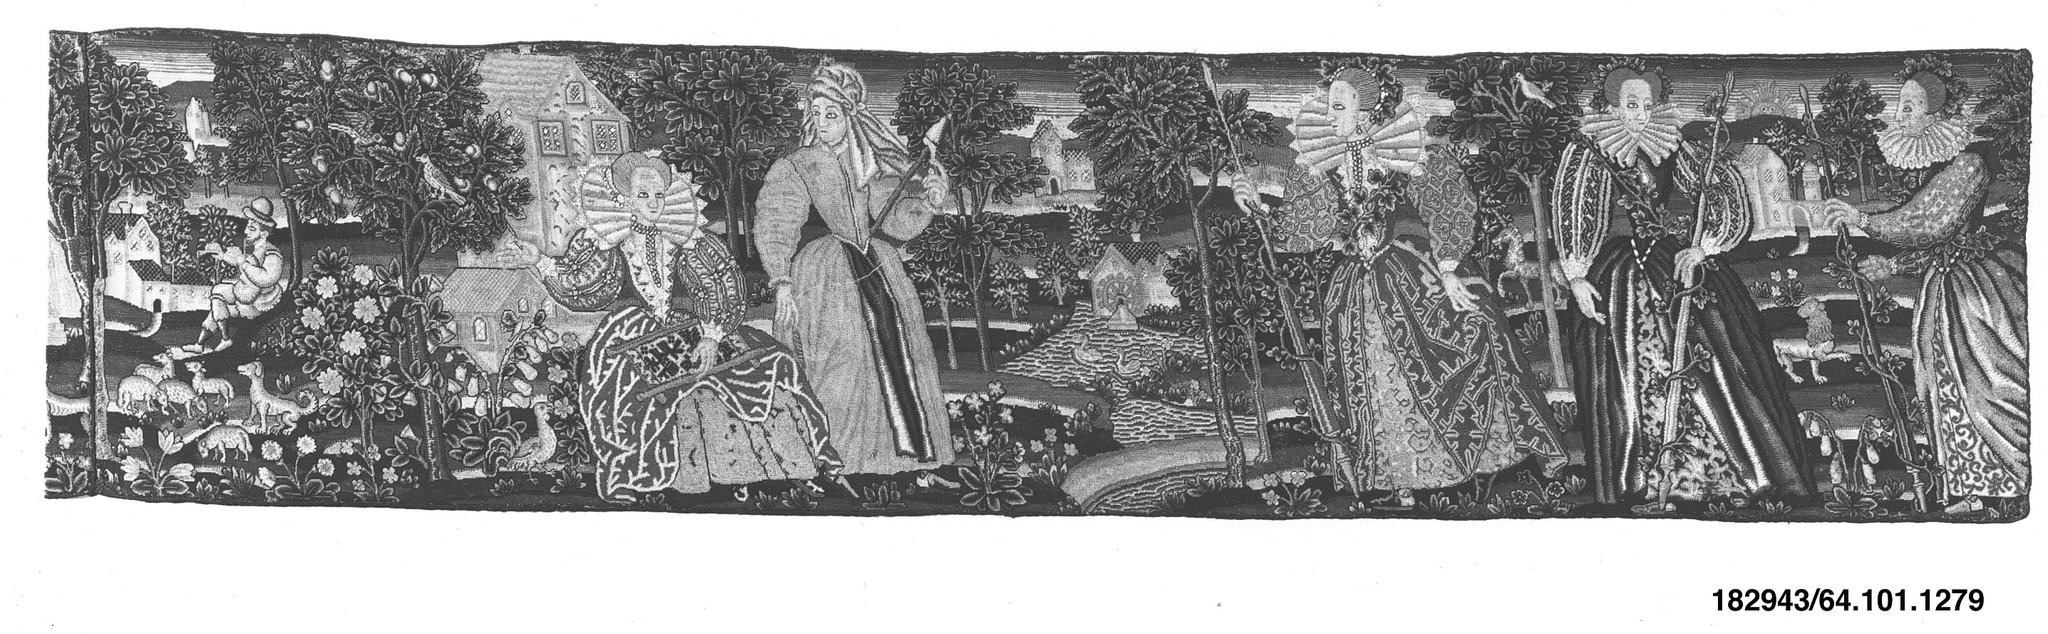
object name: valance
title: The Story of Philomela (one of two)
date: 1600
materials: canvas, silk, wool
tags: birds,houses,men,women,trees